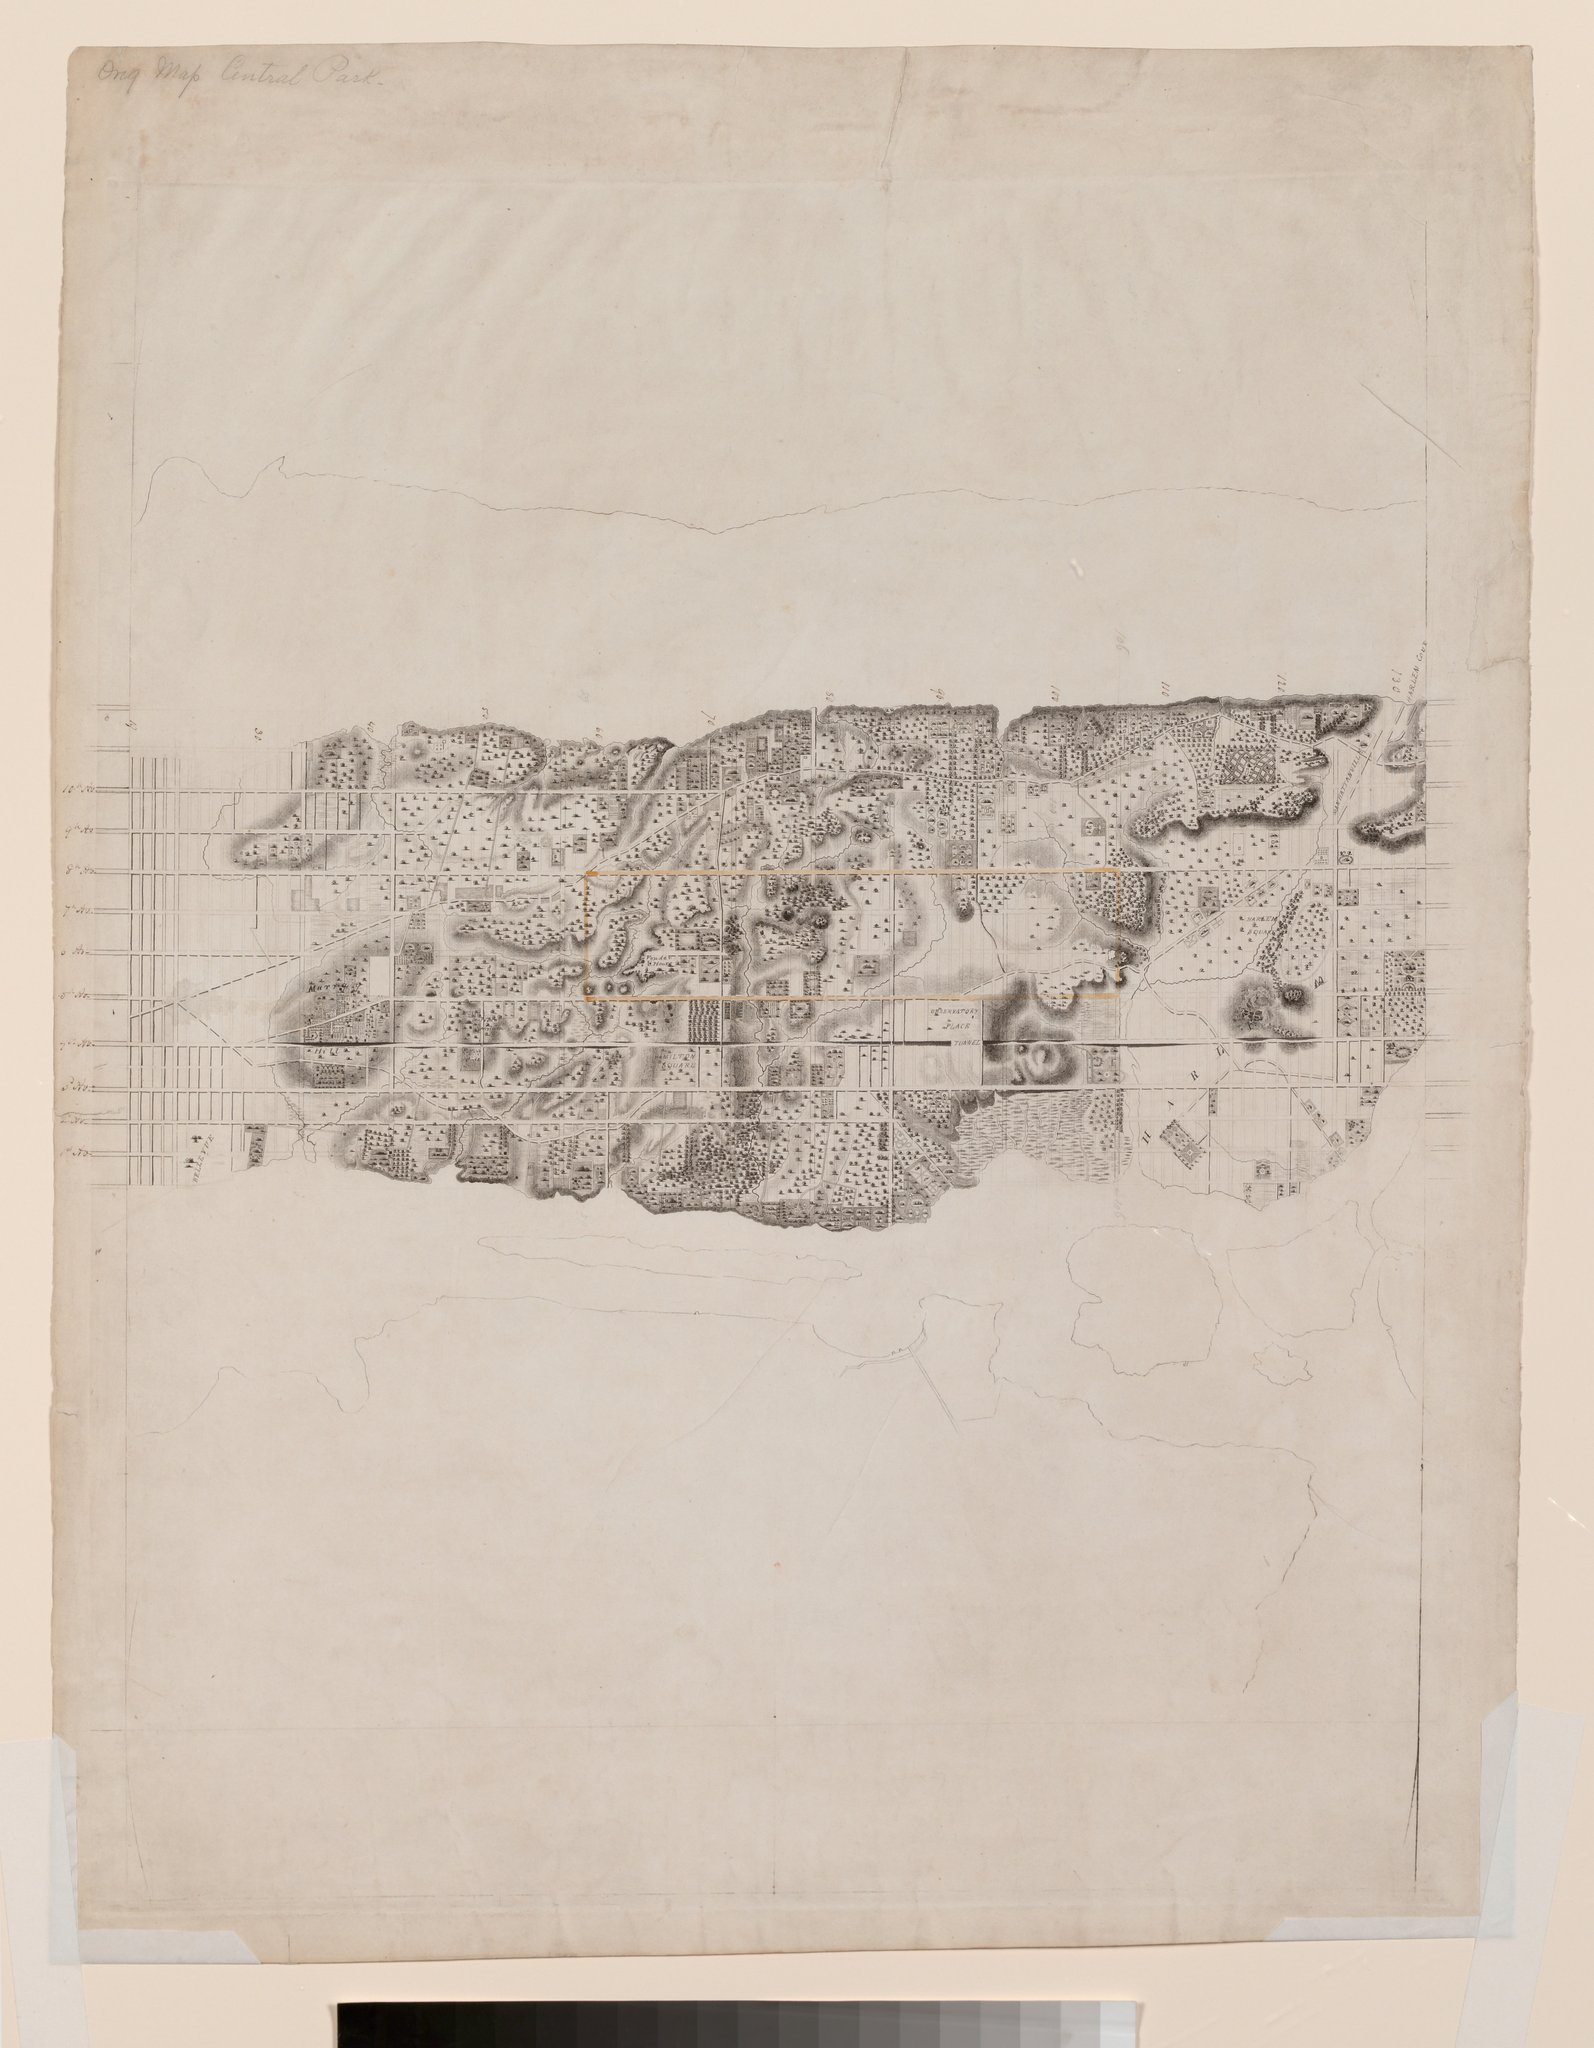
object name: print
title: Topographical Map of the City and County of New-York and the Adjacent Country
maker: david h. burr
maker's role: artist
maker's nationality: american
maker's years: 1829-1850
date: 1836-1858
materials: chalk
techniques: engraving, wash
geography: new york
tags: maps